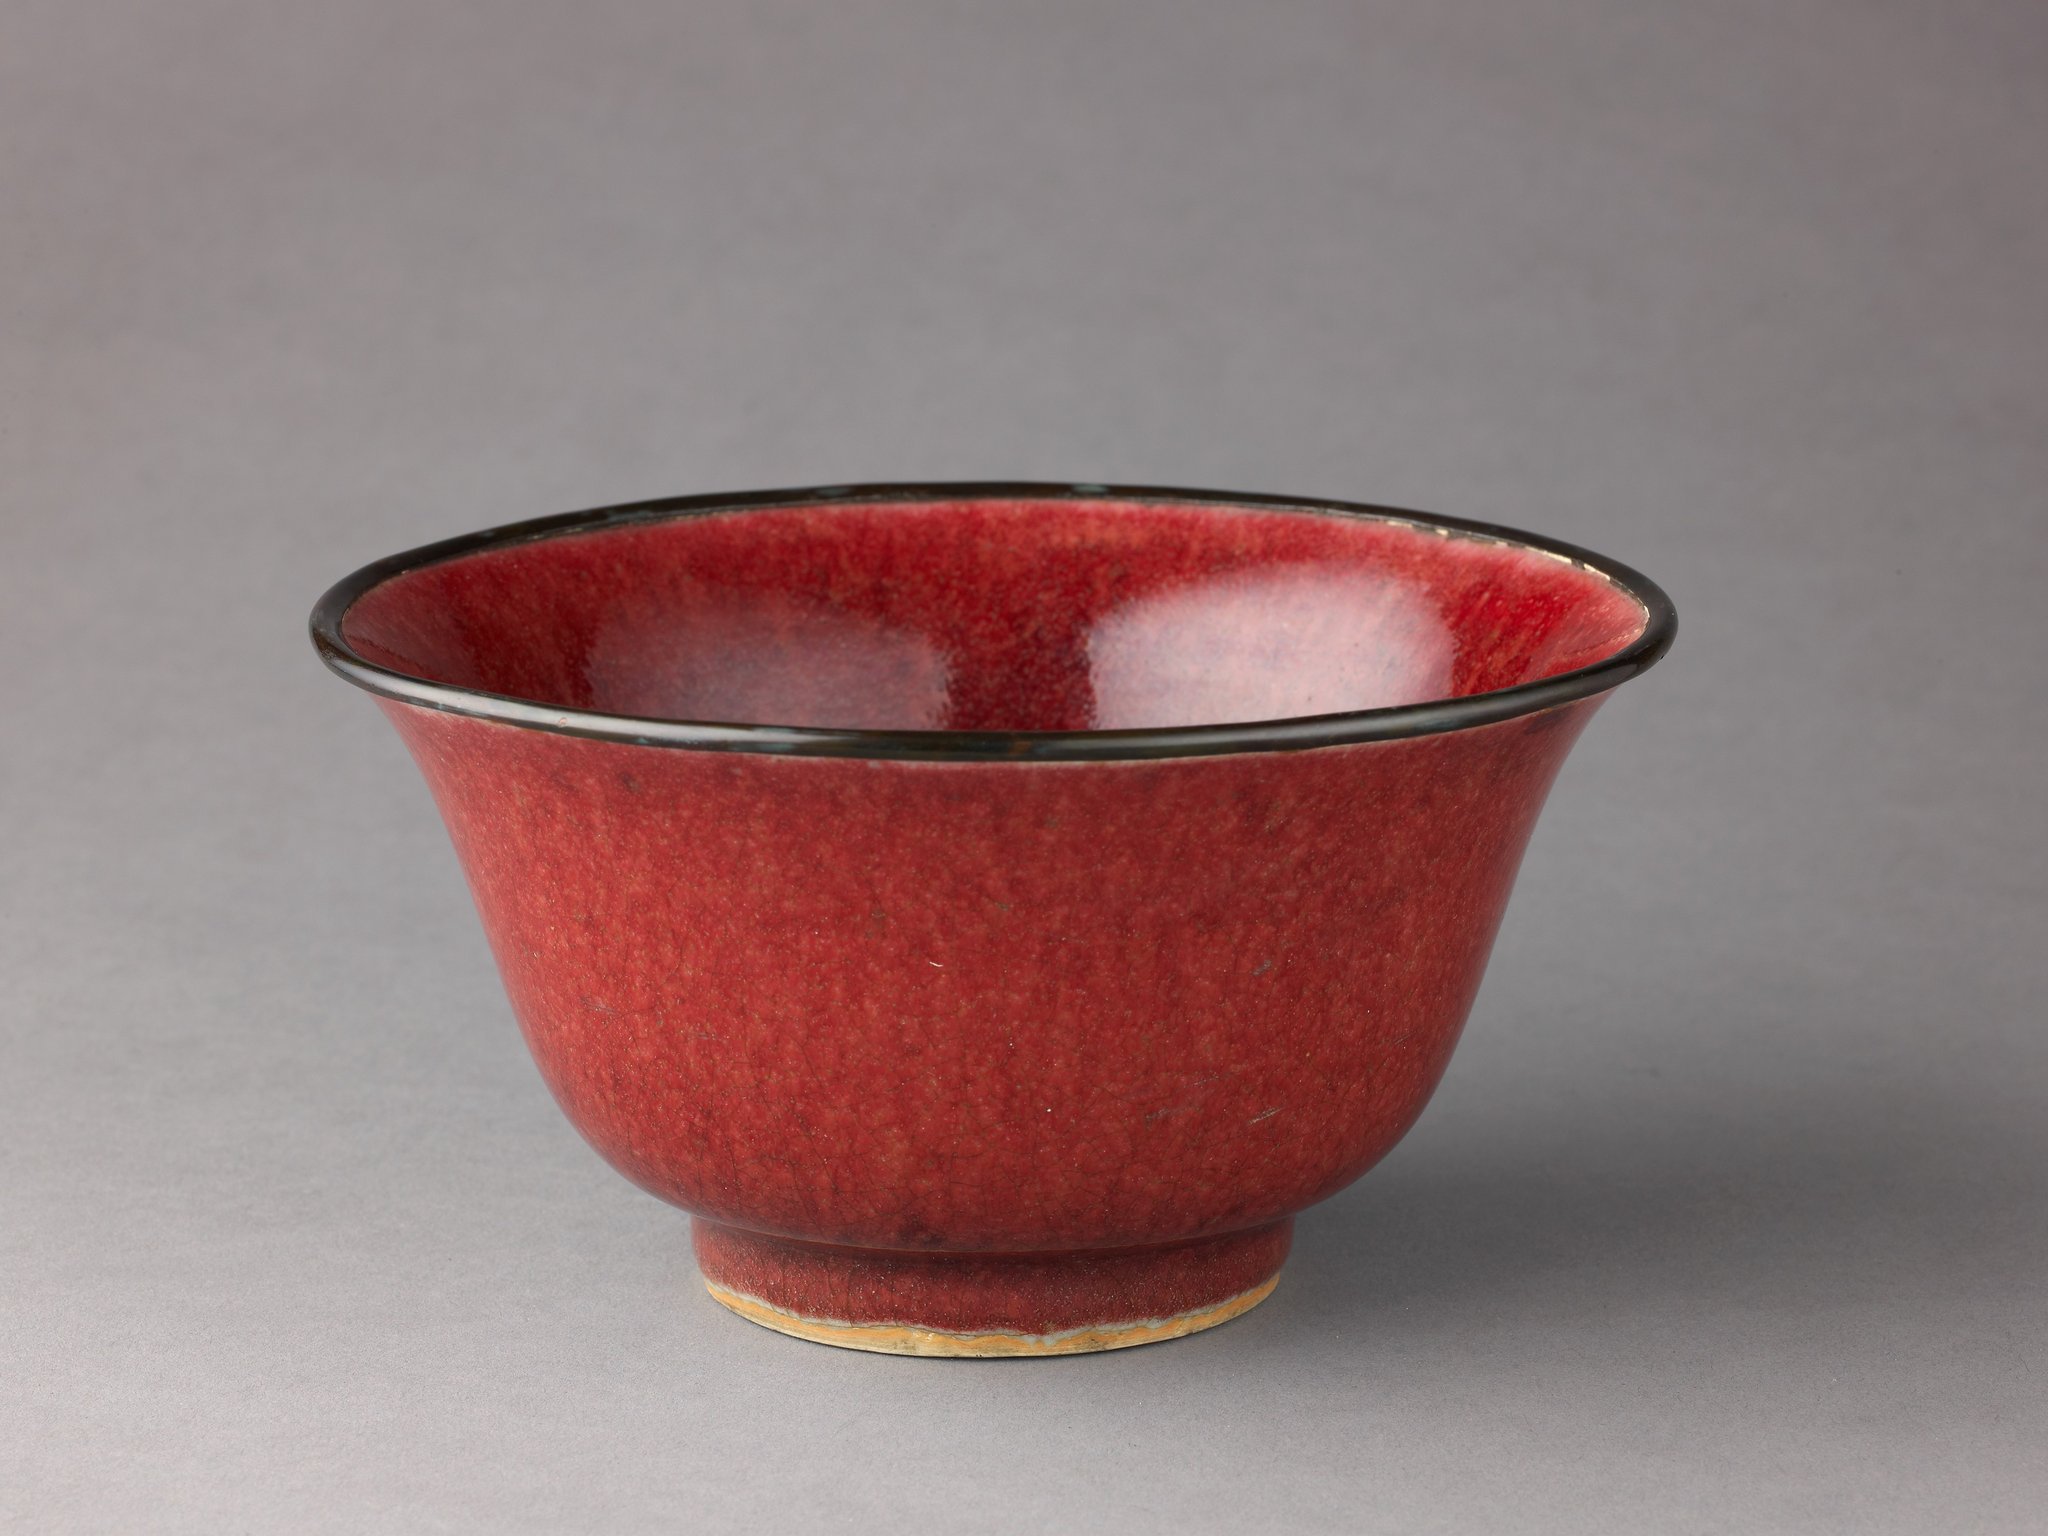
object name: bowl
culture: chinese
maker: chinese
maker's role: artist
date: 1701-1800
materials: glaze, porcelain